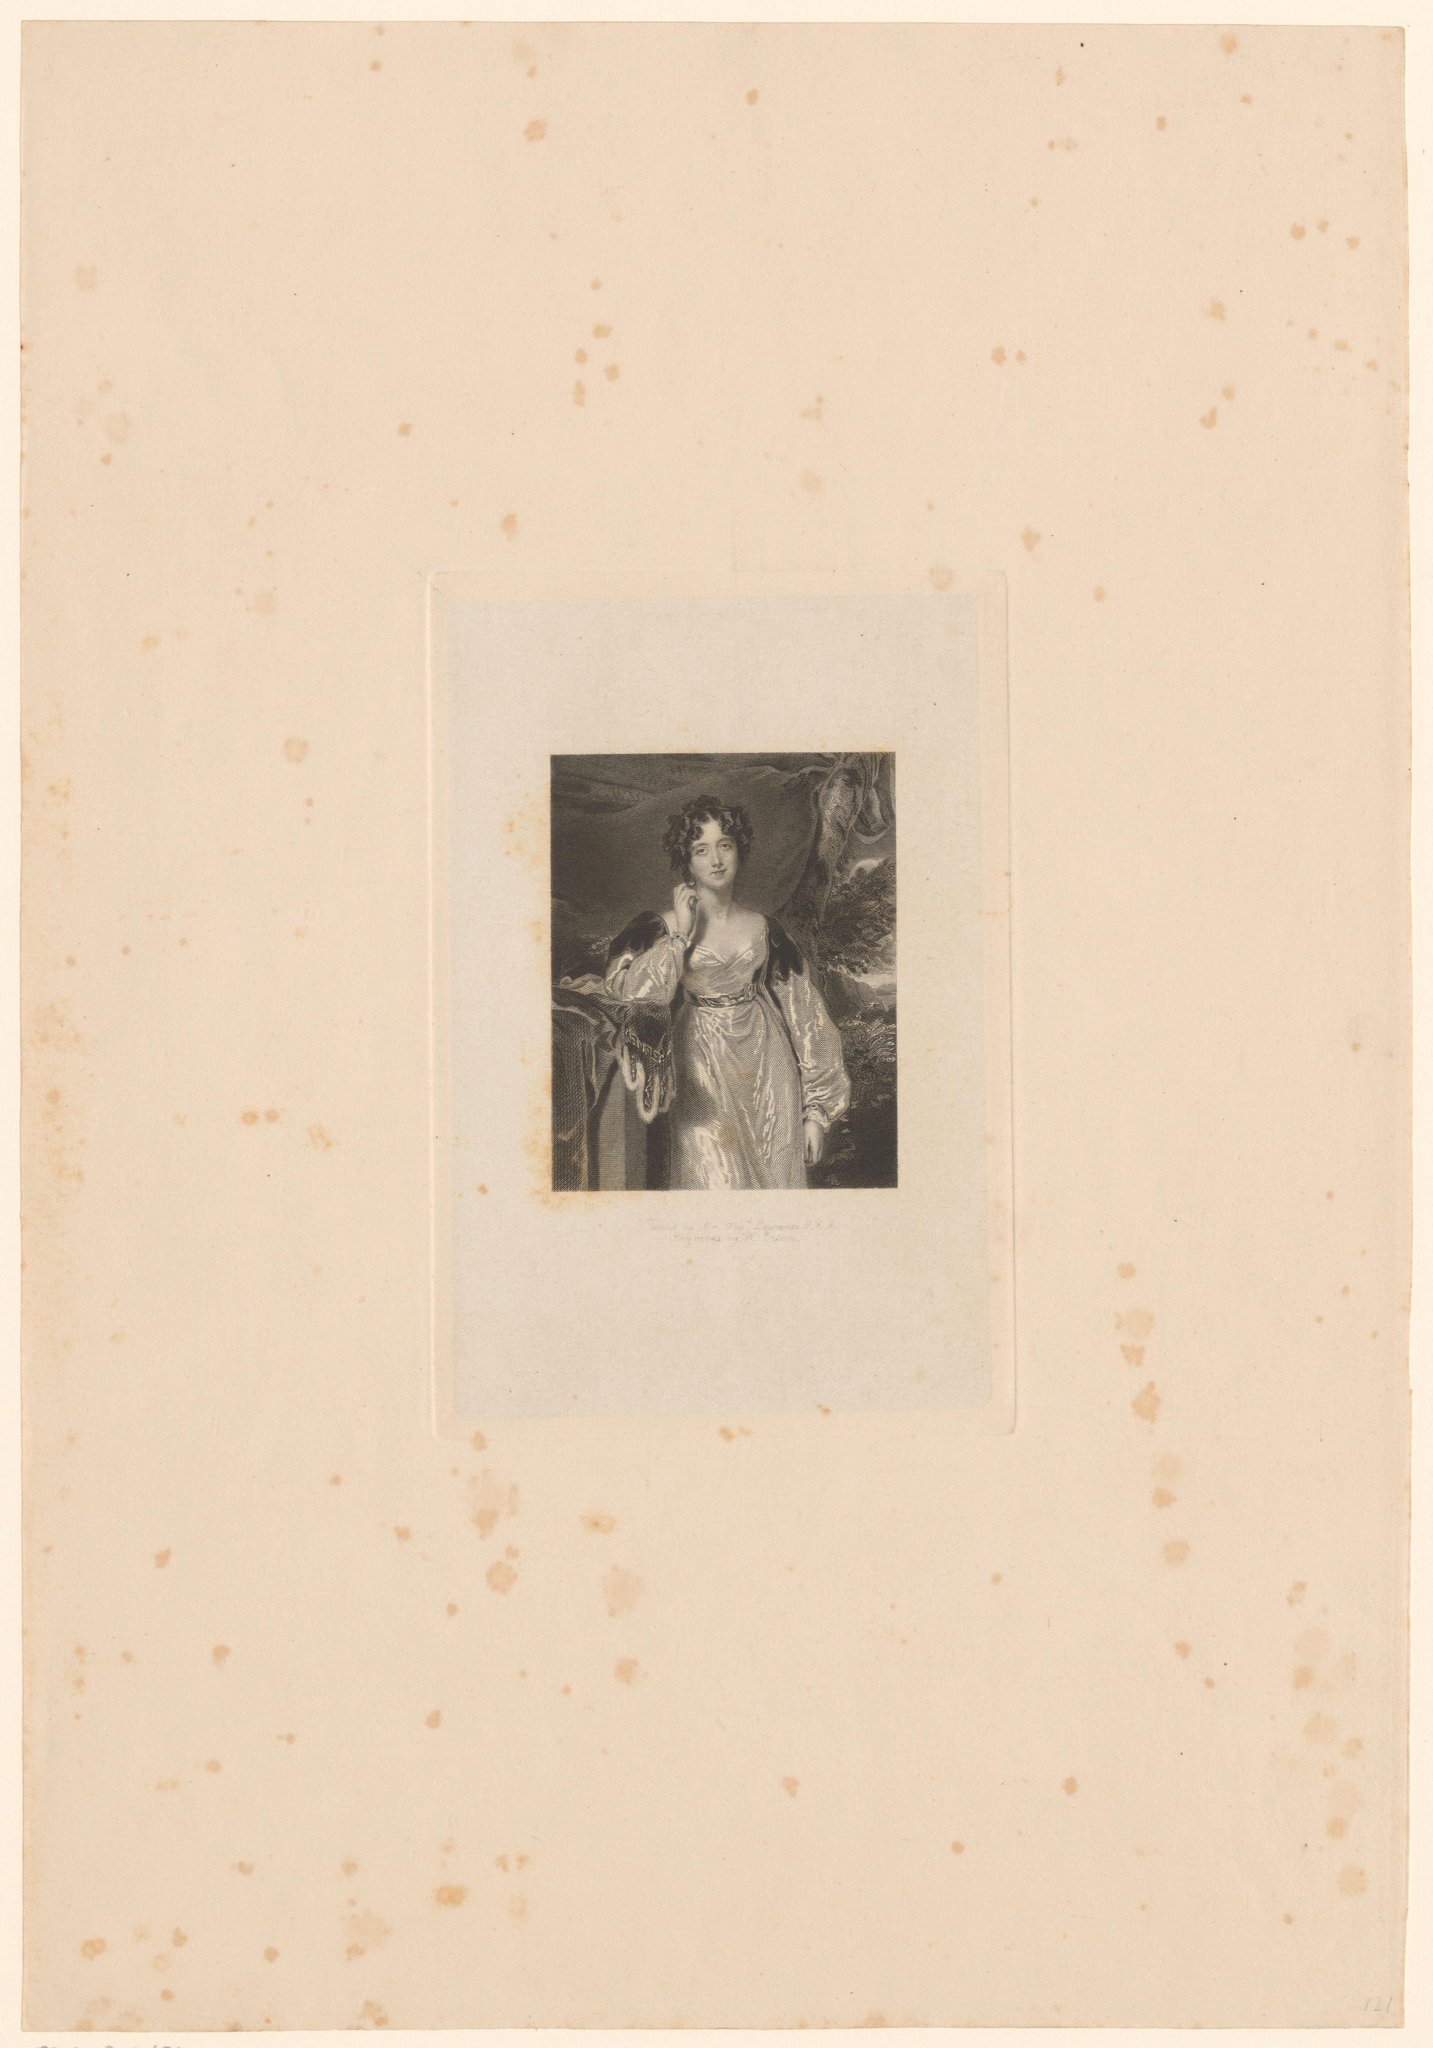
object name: print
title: Portret van Frances Mary Gascoyne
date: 1831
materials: paper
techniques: etching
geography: london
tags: historical persons - bb - woman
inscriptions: collector's mark: Lugt 2228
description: Prent uit: Watts, Alaric. The Literary Souvenir, or, Cabinet of Poetry and Romance. Londen: Longman, Rees, Orme, Brown & Green, 1832, p. 71.